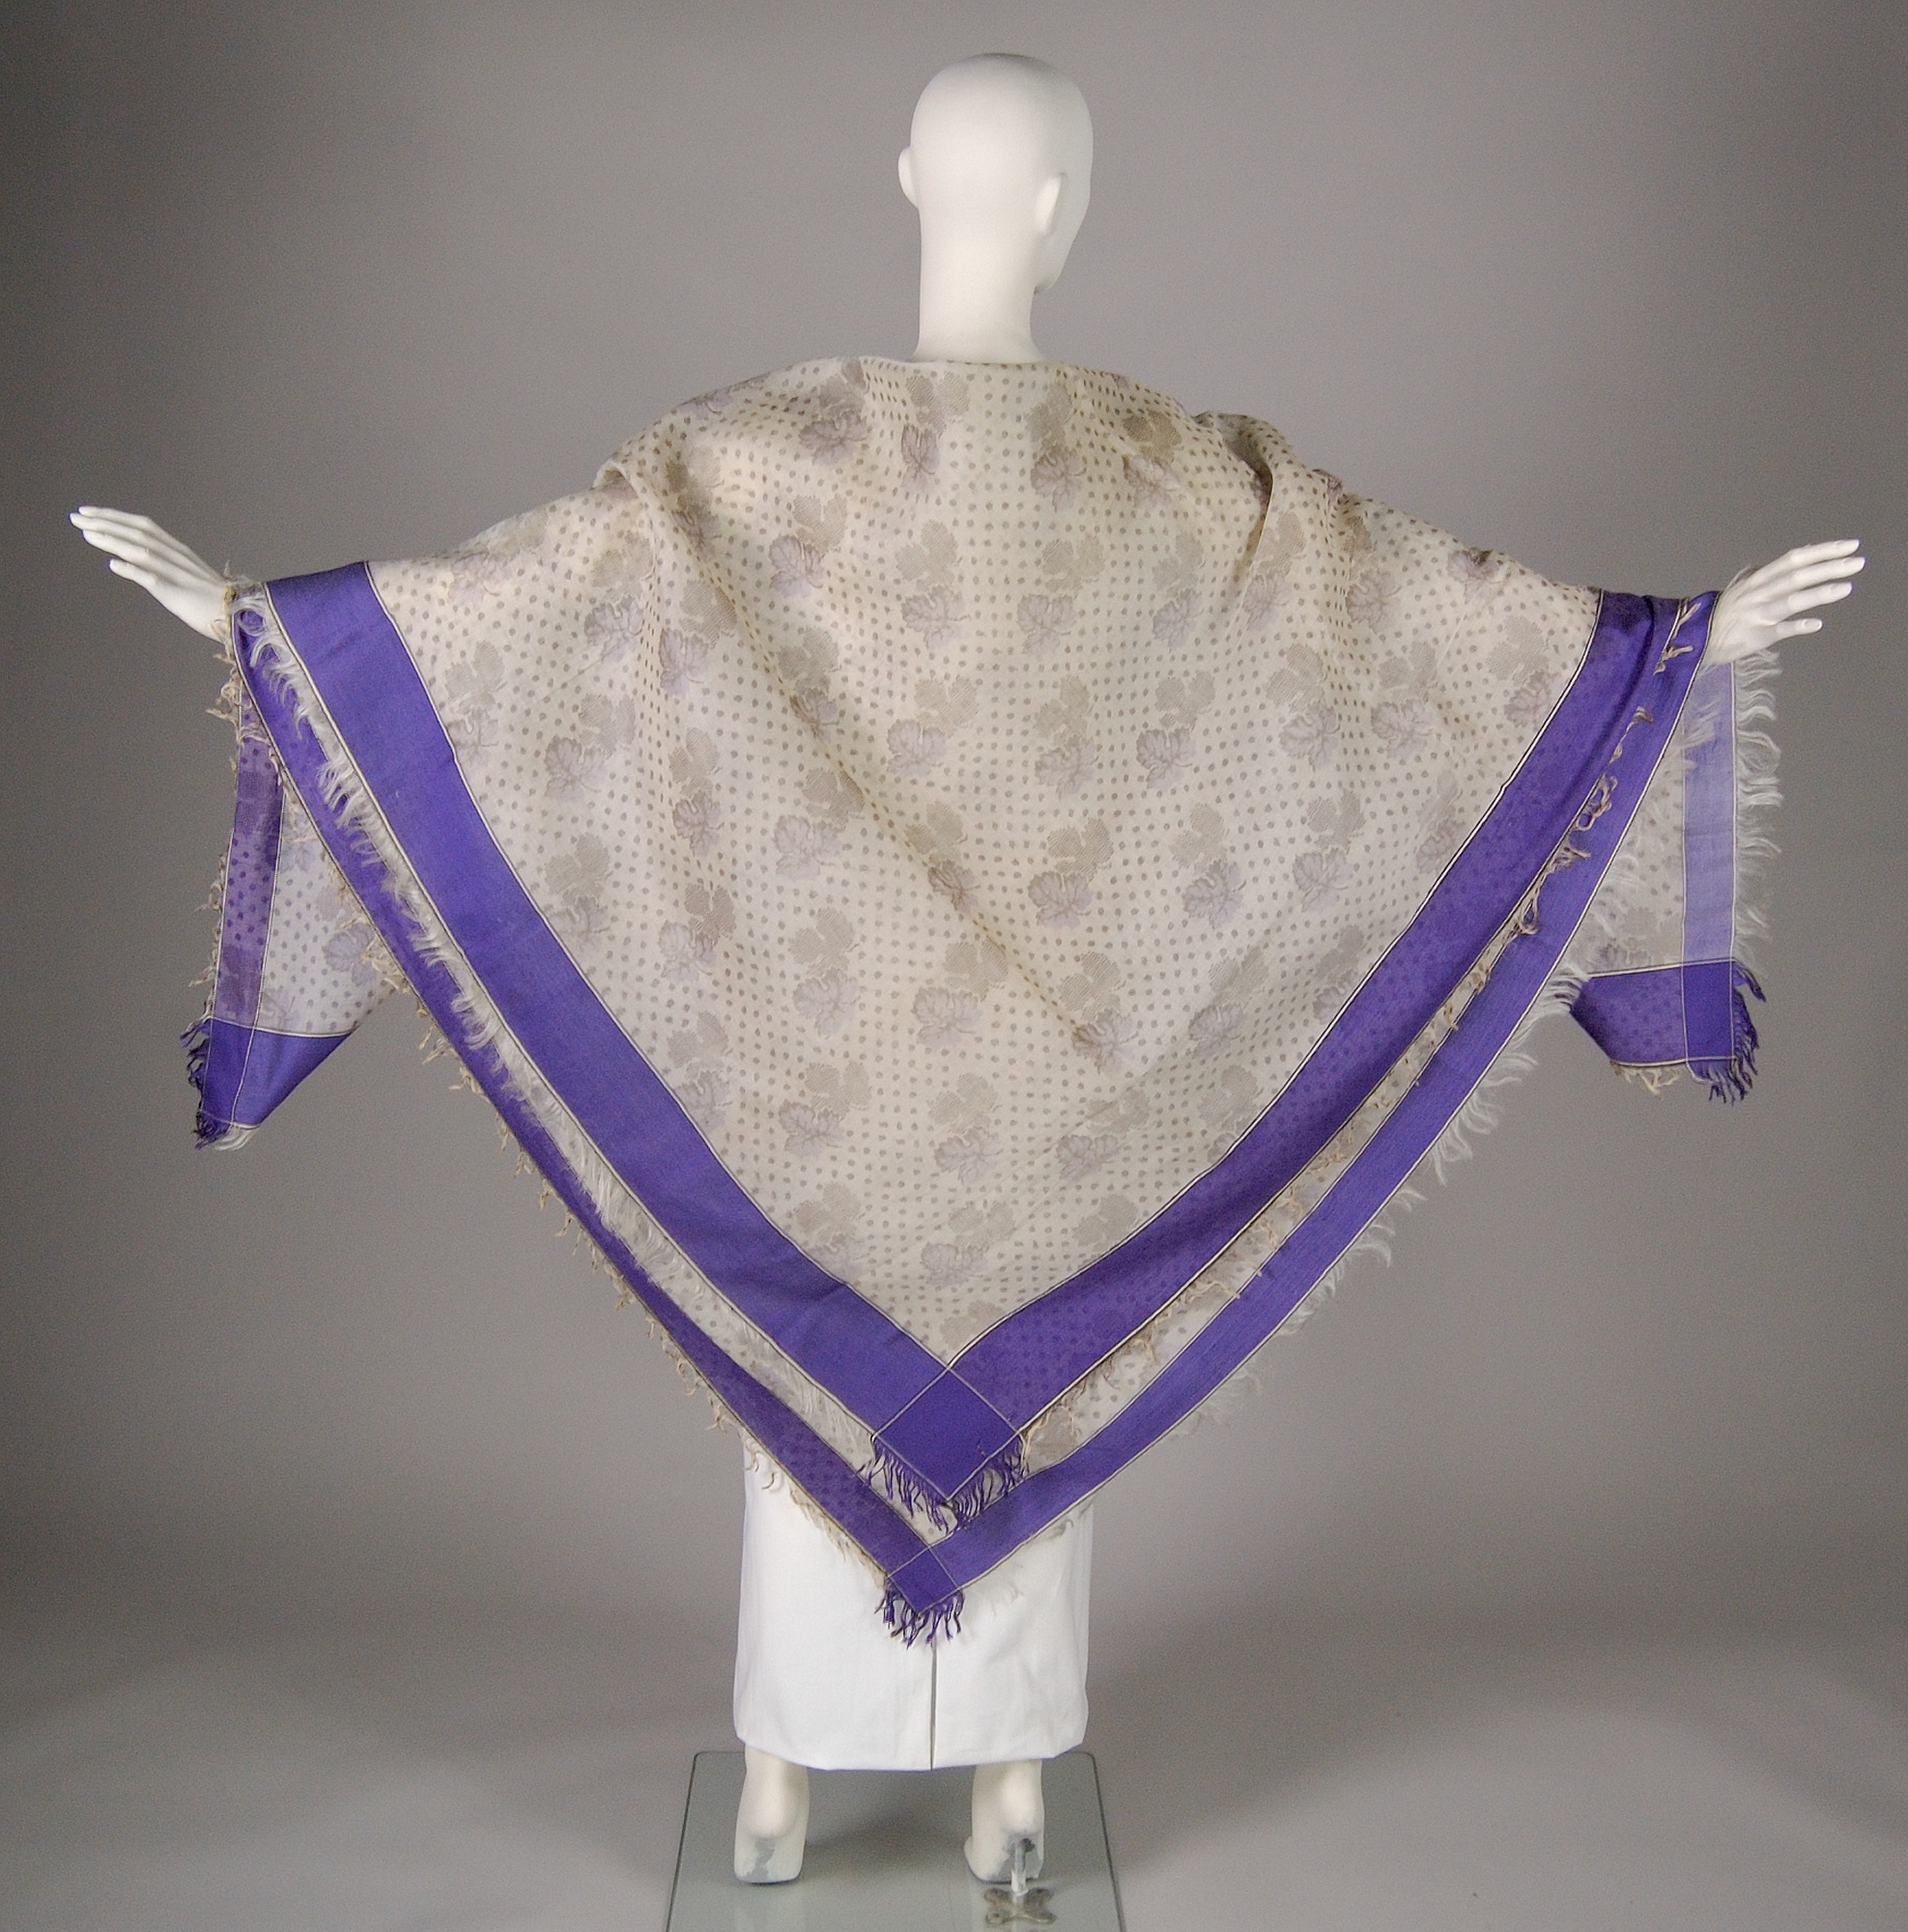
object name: shawl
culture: american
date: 1840-1860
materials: silk, wool